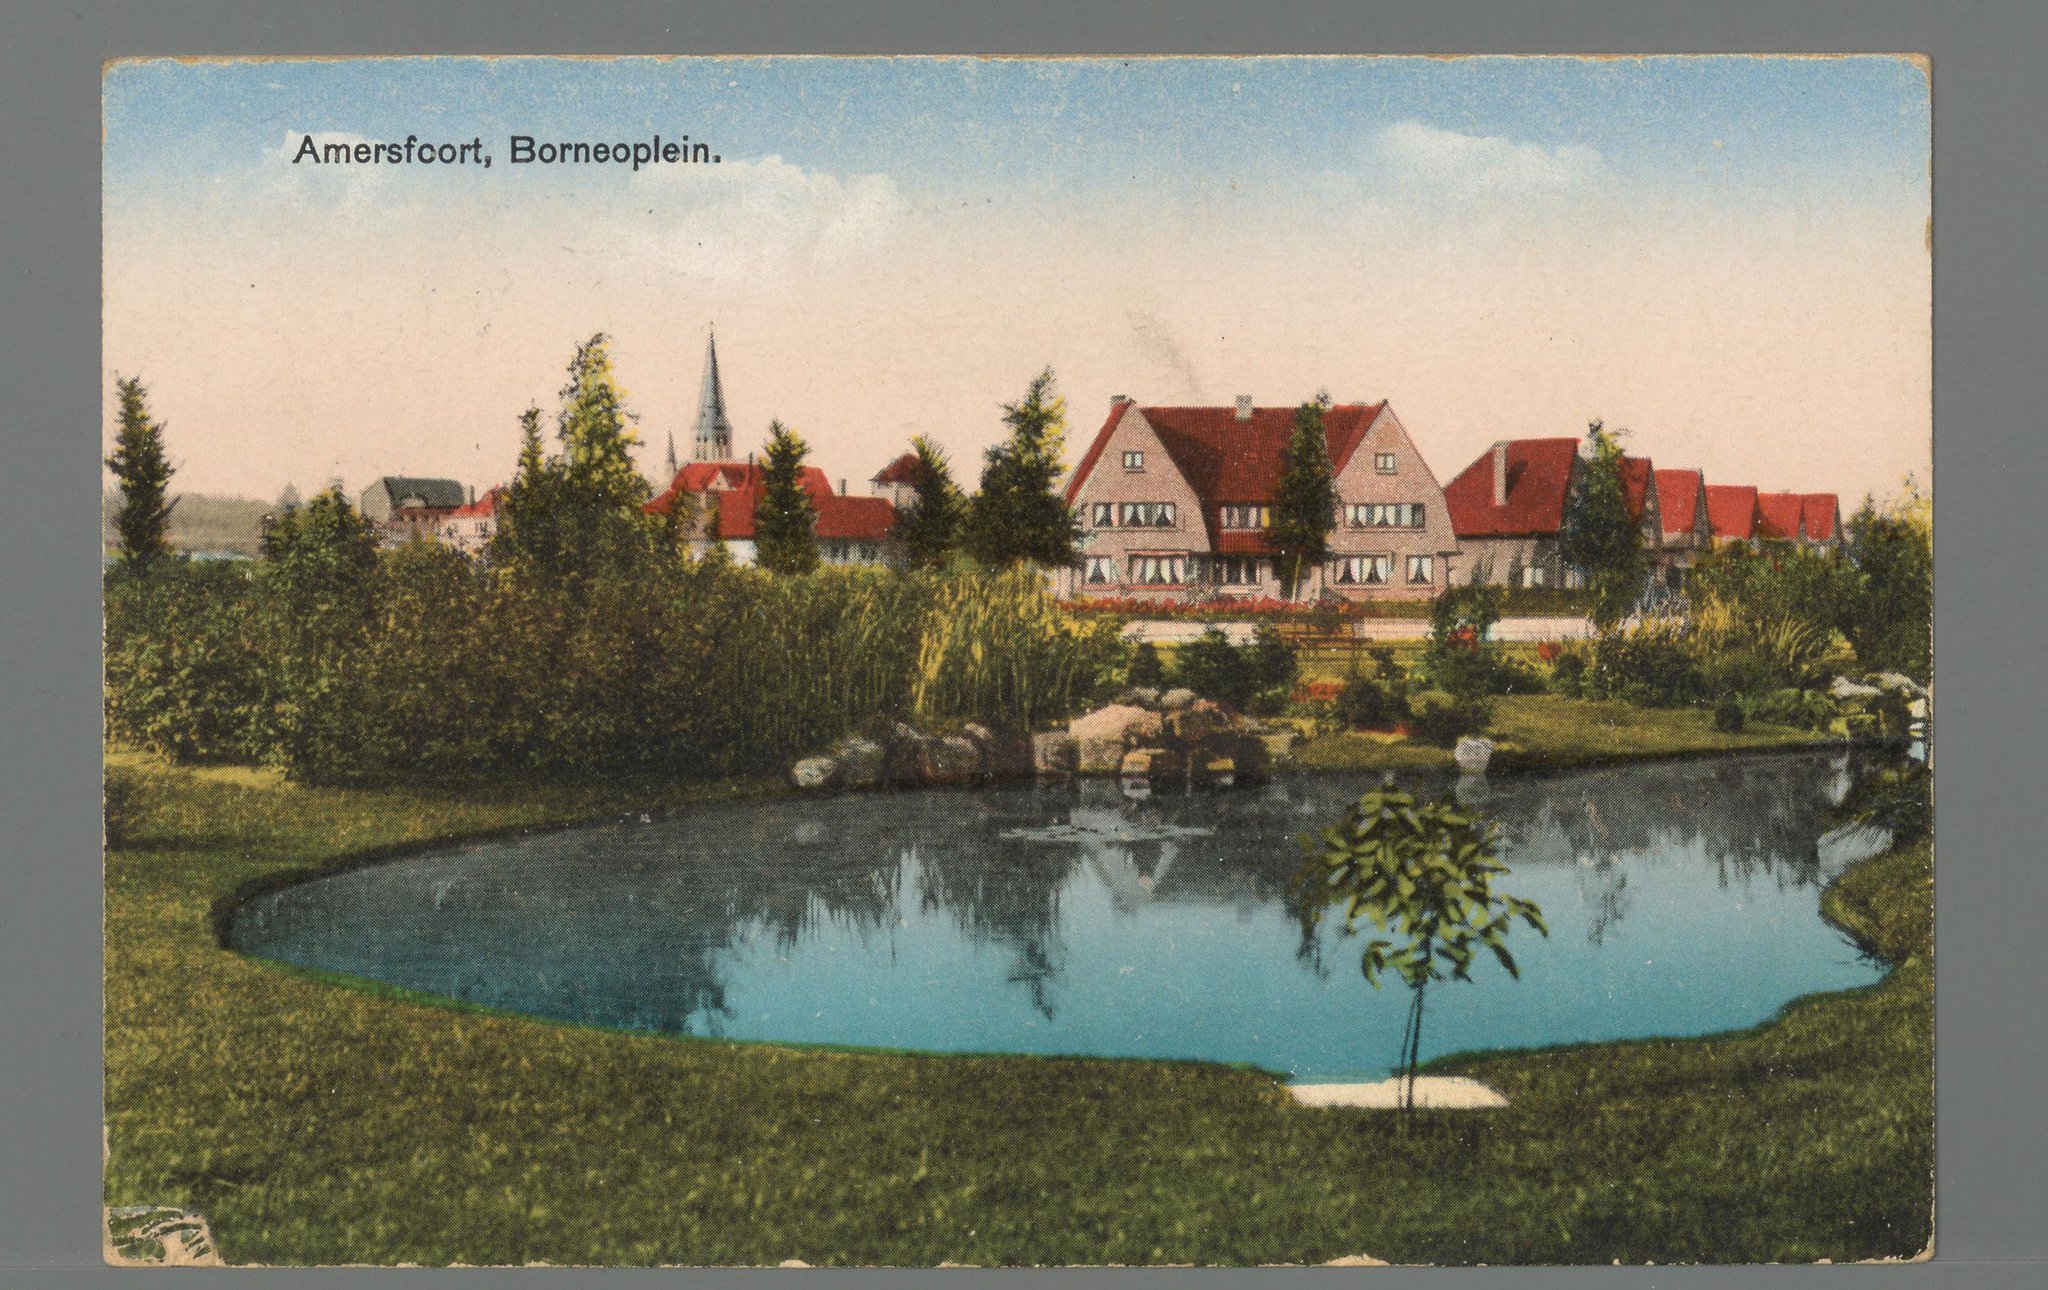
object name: photomechanical print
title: Amersfoort, Borneoplein.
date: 1905-1930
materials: cardboard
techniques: lithograph, writing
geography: amersfoort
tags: pond, pool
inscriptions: postage stamp